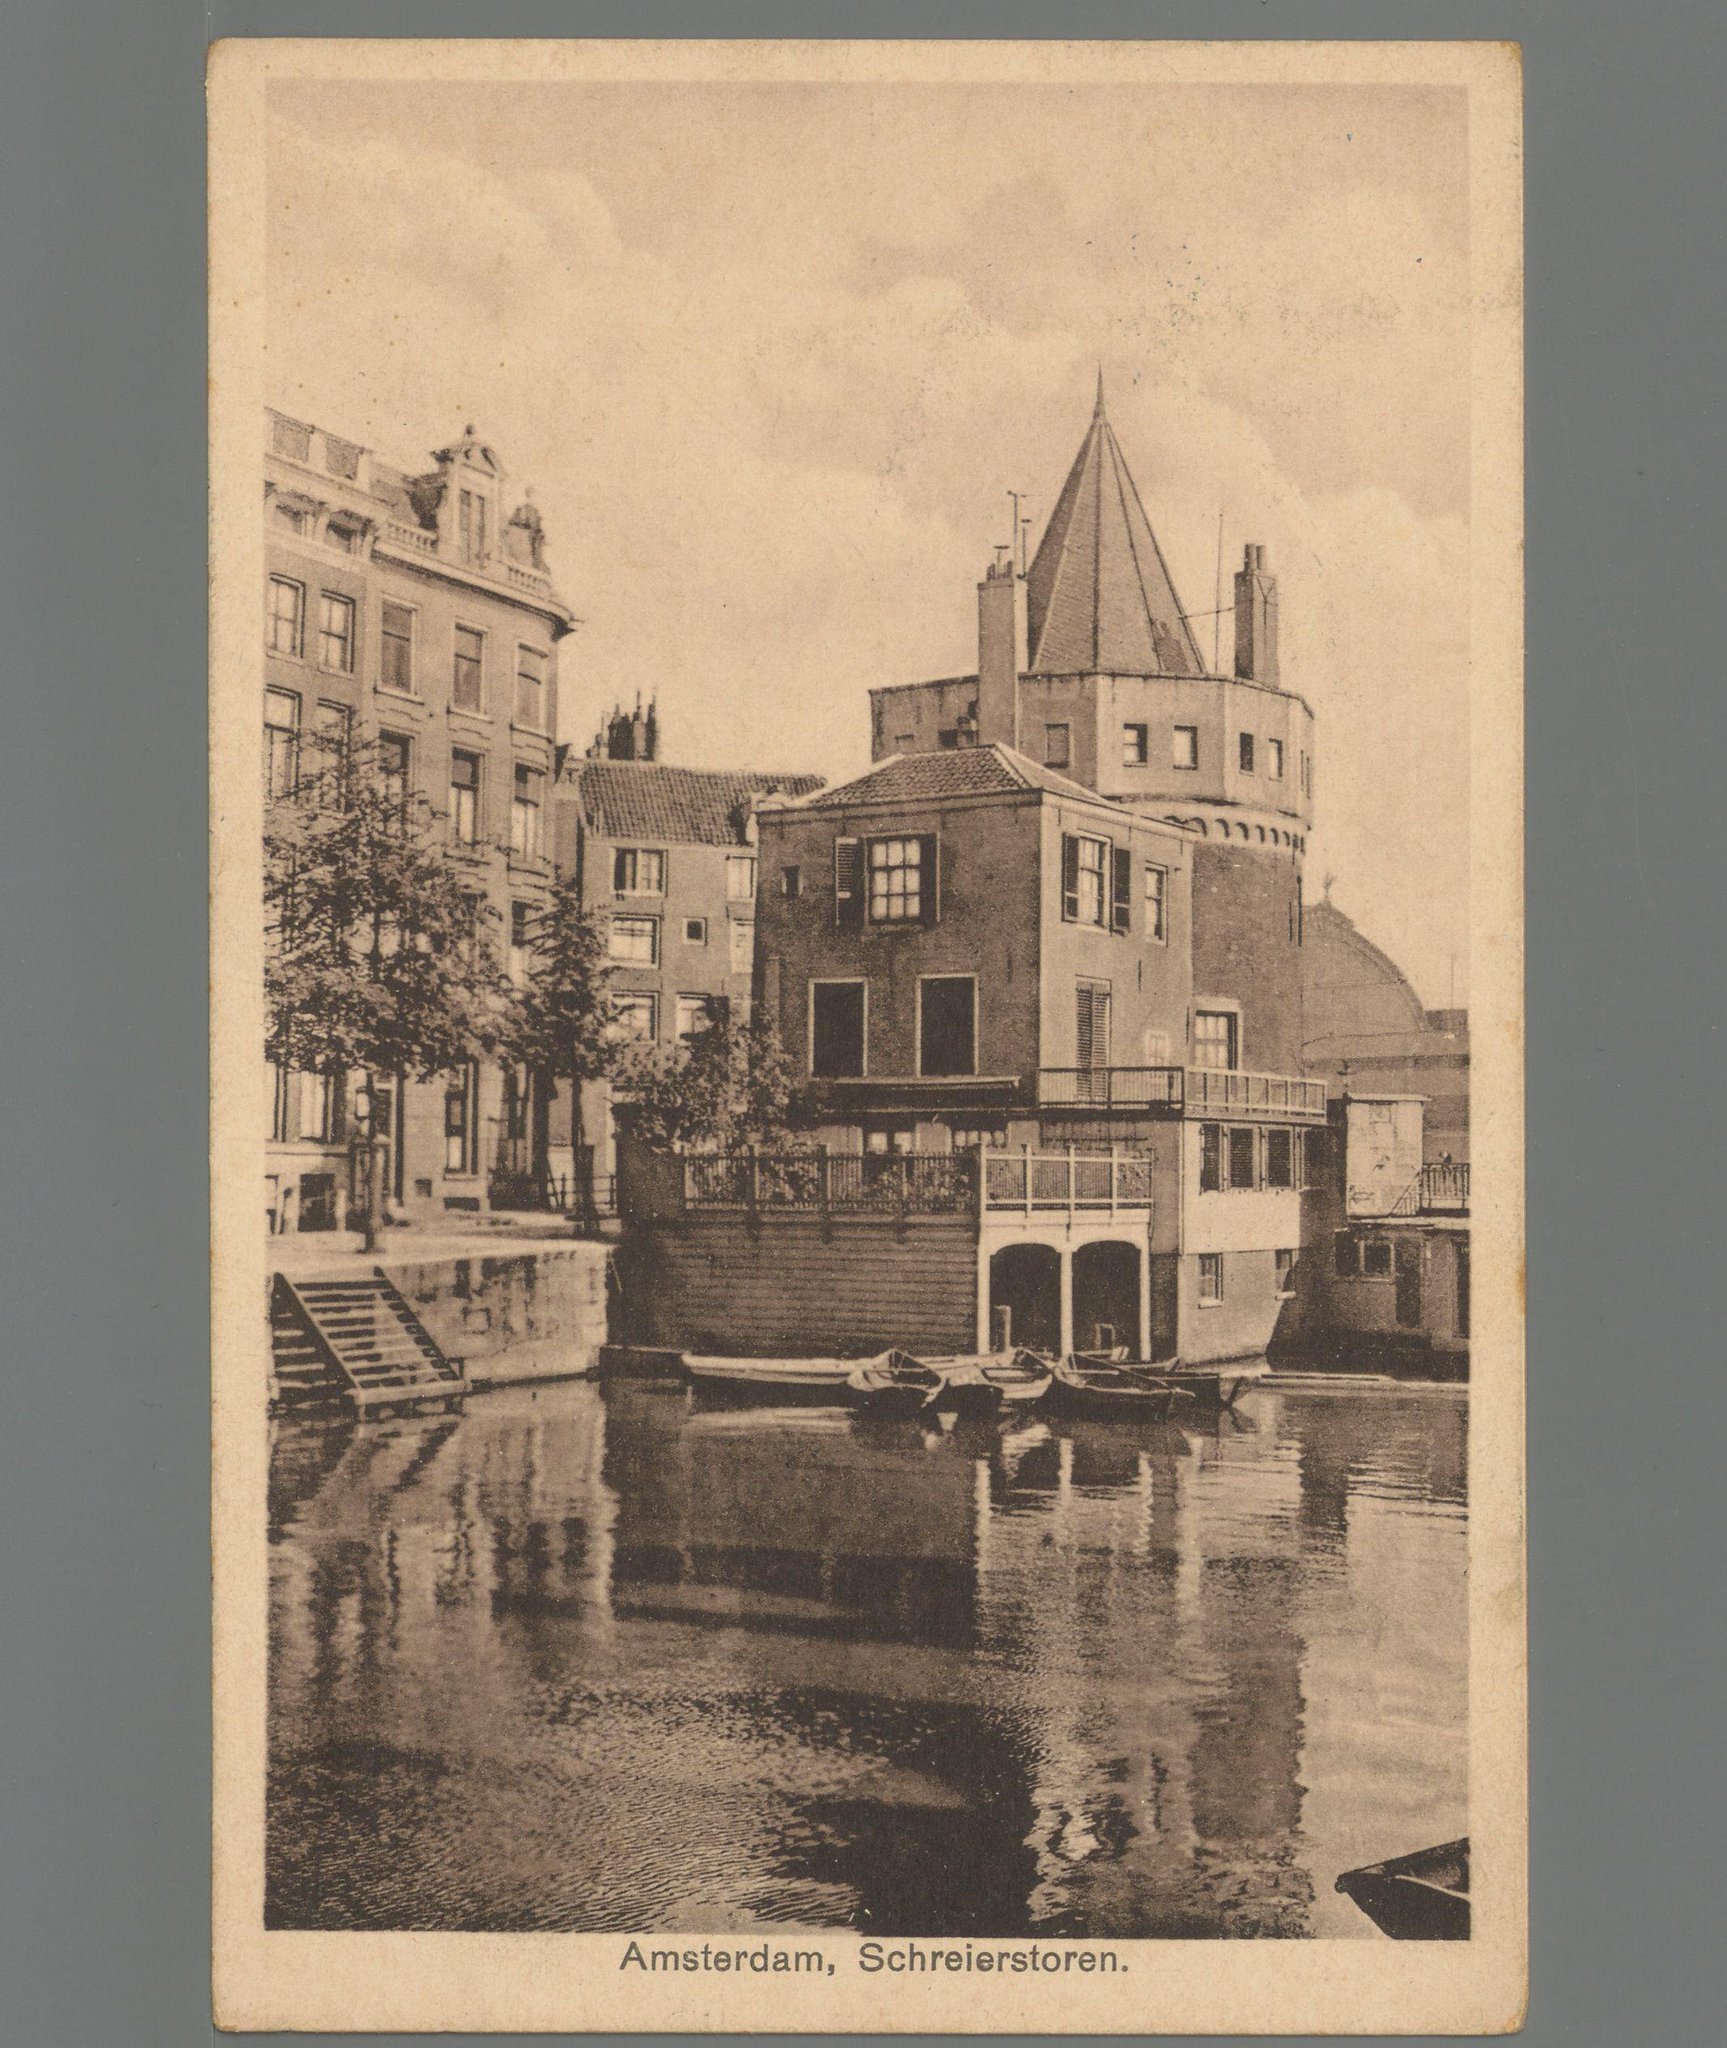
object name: photomechanical print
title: Amsterdam, Schreierstoren.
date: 1913-1928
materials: cardboard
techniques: photograph, writing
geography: amsterdam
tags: tower, clock tower ~ monumental adornment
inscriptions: postage stamp